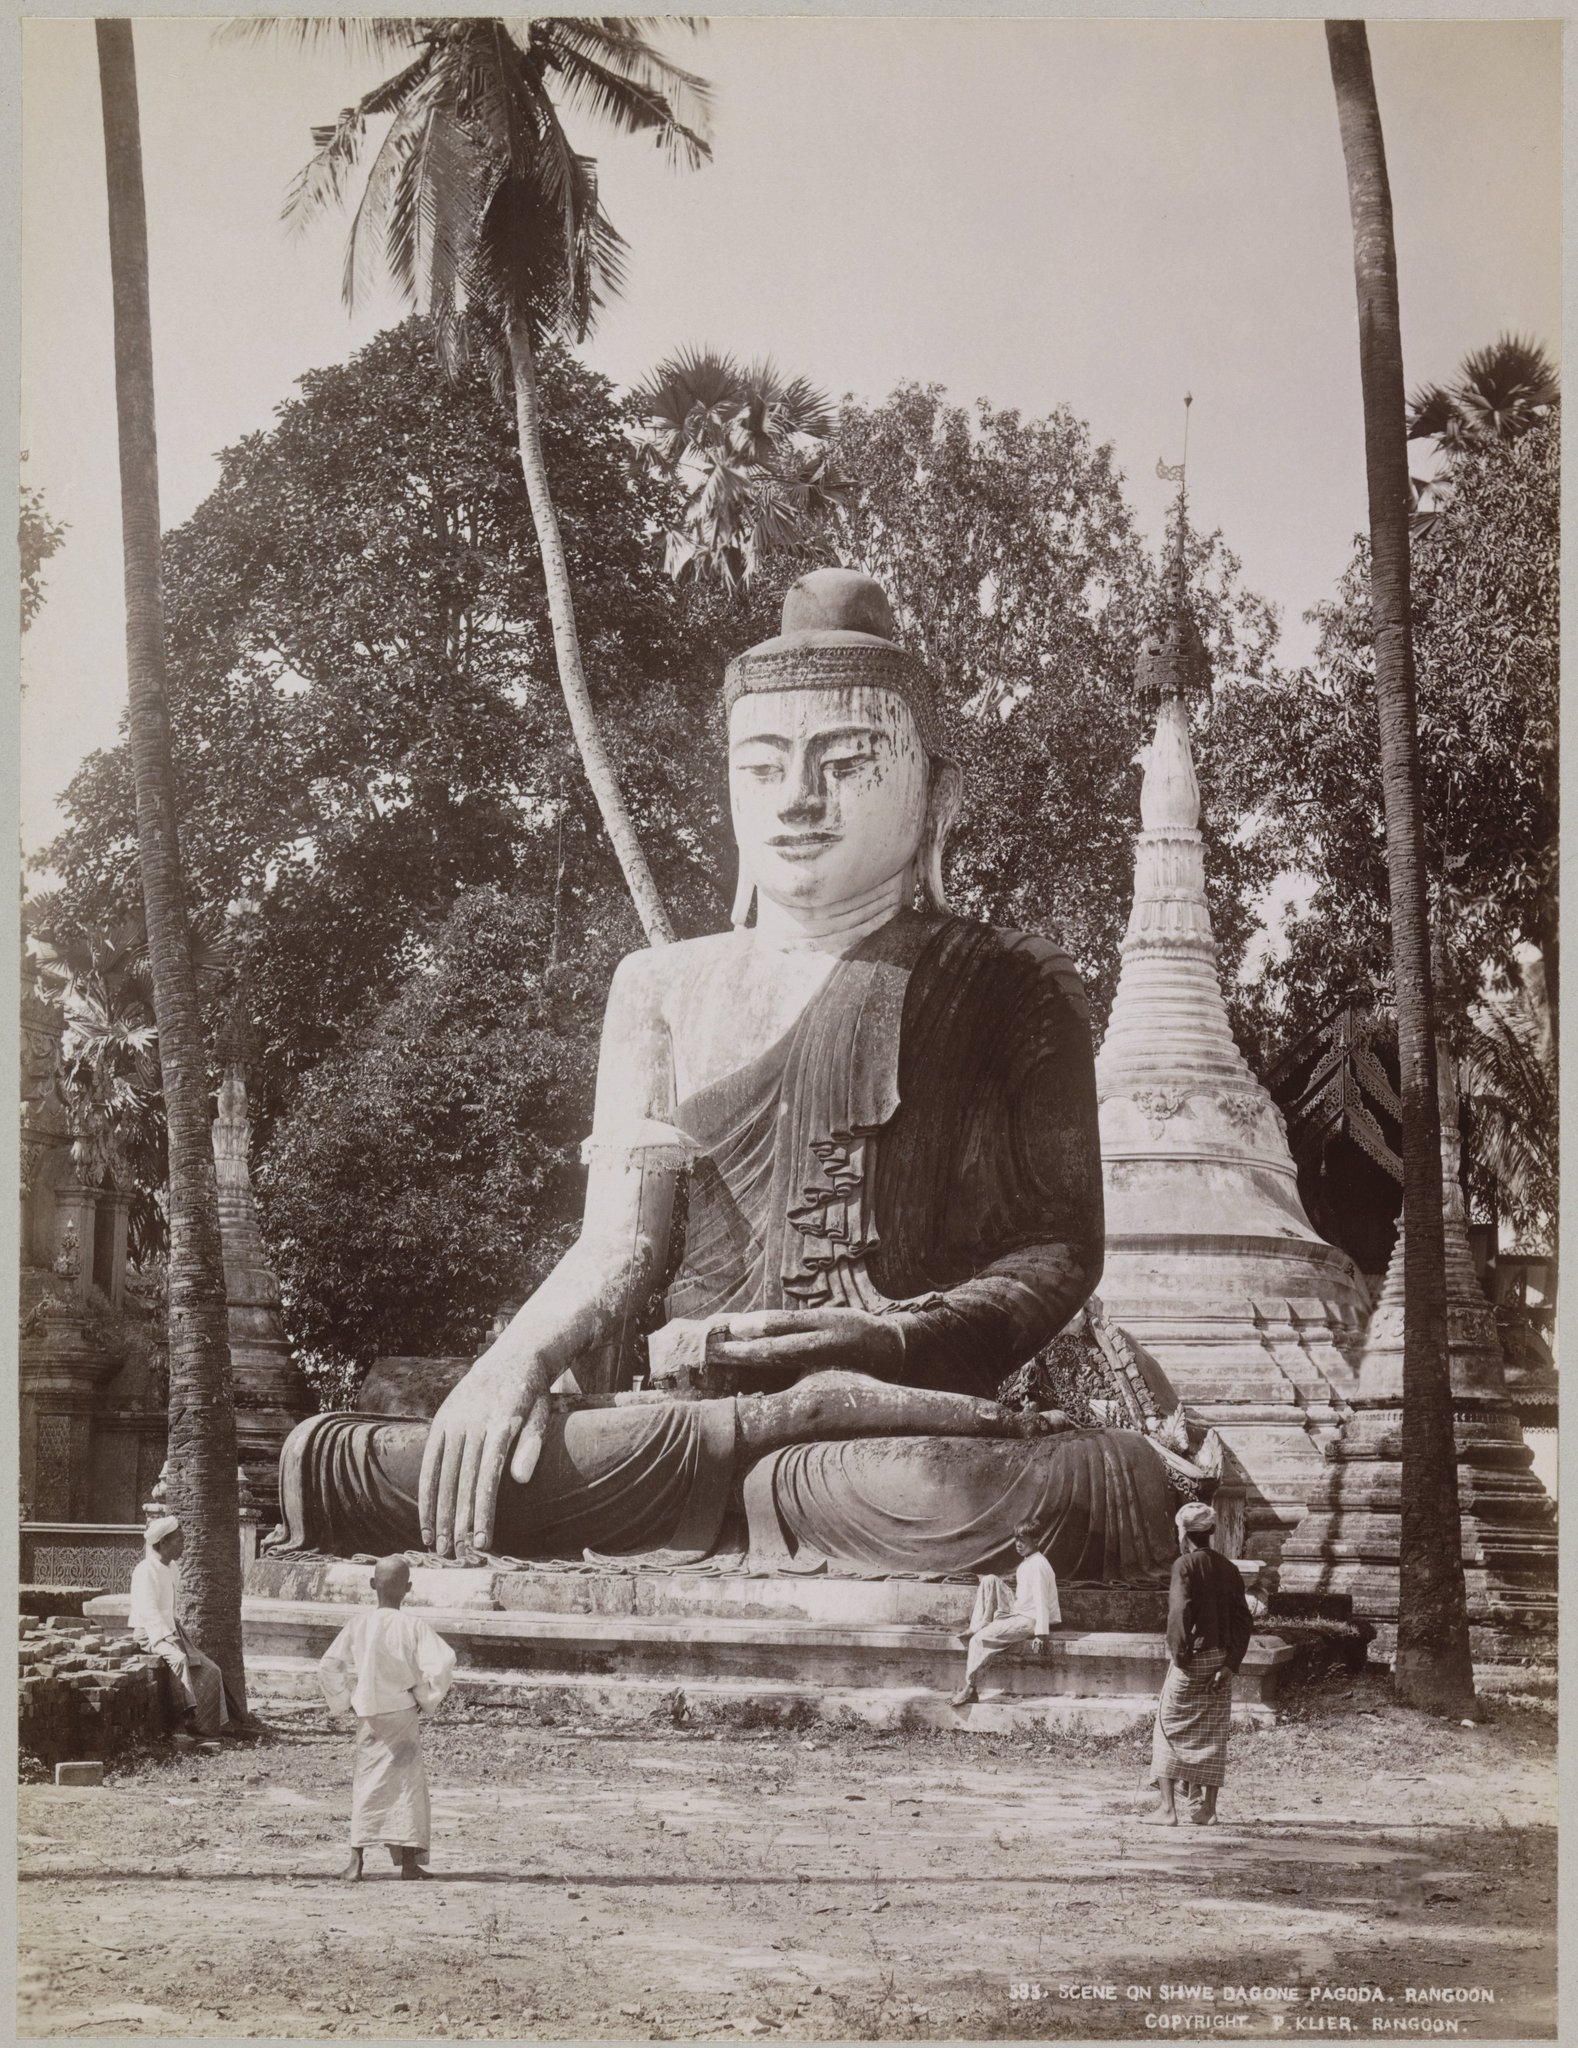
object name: photograph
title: Huge Buddha idol at the Shwedagon pagoda, Yangon, Myanmar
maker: philip adolphe klier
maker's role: fotograaf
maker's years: 1845-1911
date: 1895-1915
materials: cardboard, paper, photographic support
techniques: albumen print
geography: yangon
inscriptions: inscription: ‘585. Scene on Shwe Dagon Pagoda. Rangoon./ Copyright. P. Klier. Rangoon.’, number: ‘9.’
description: Boeddhabeeld met op de voorgrond vier jongens.